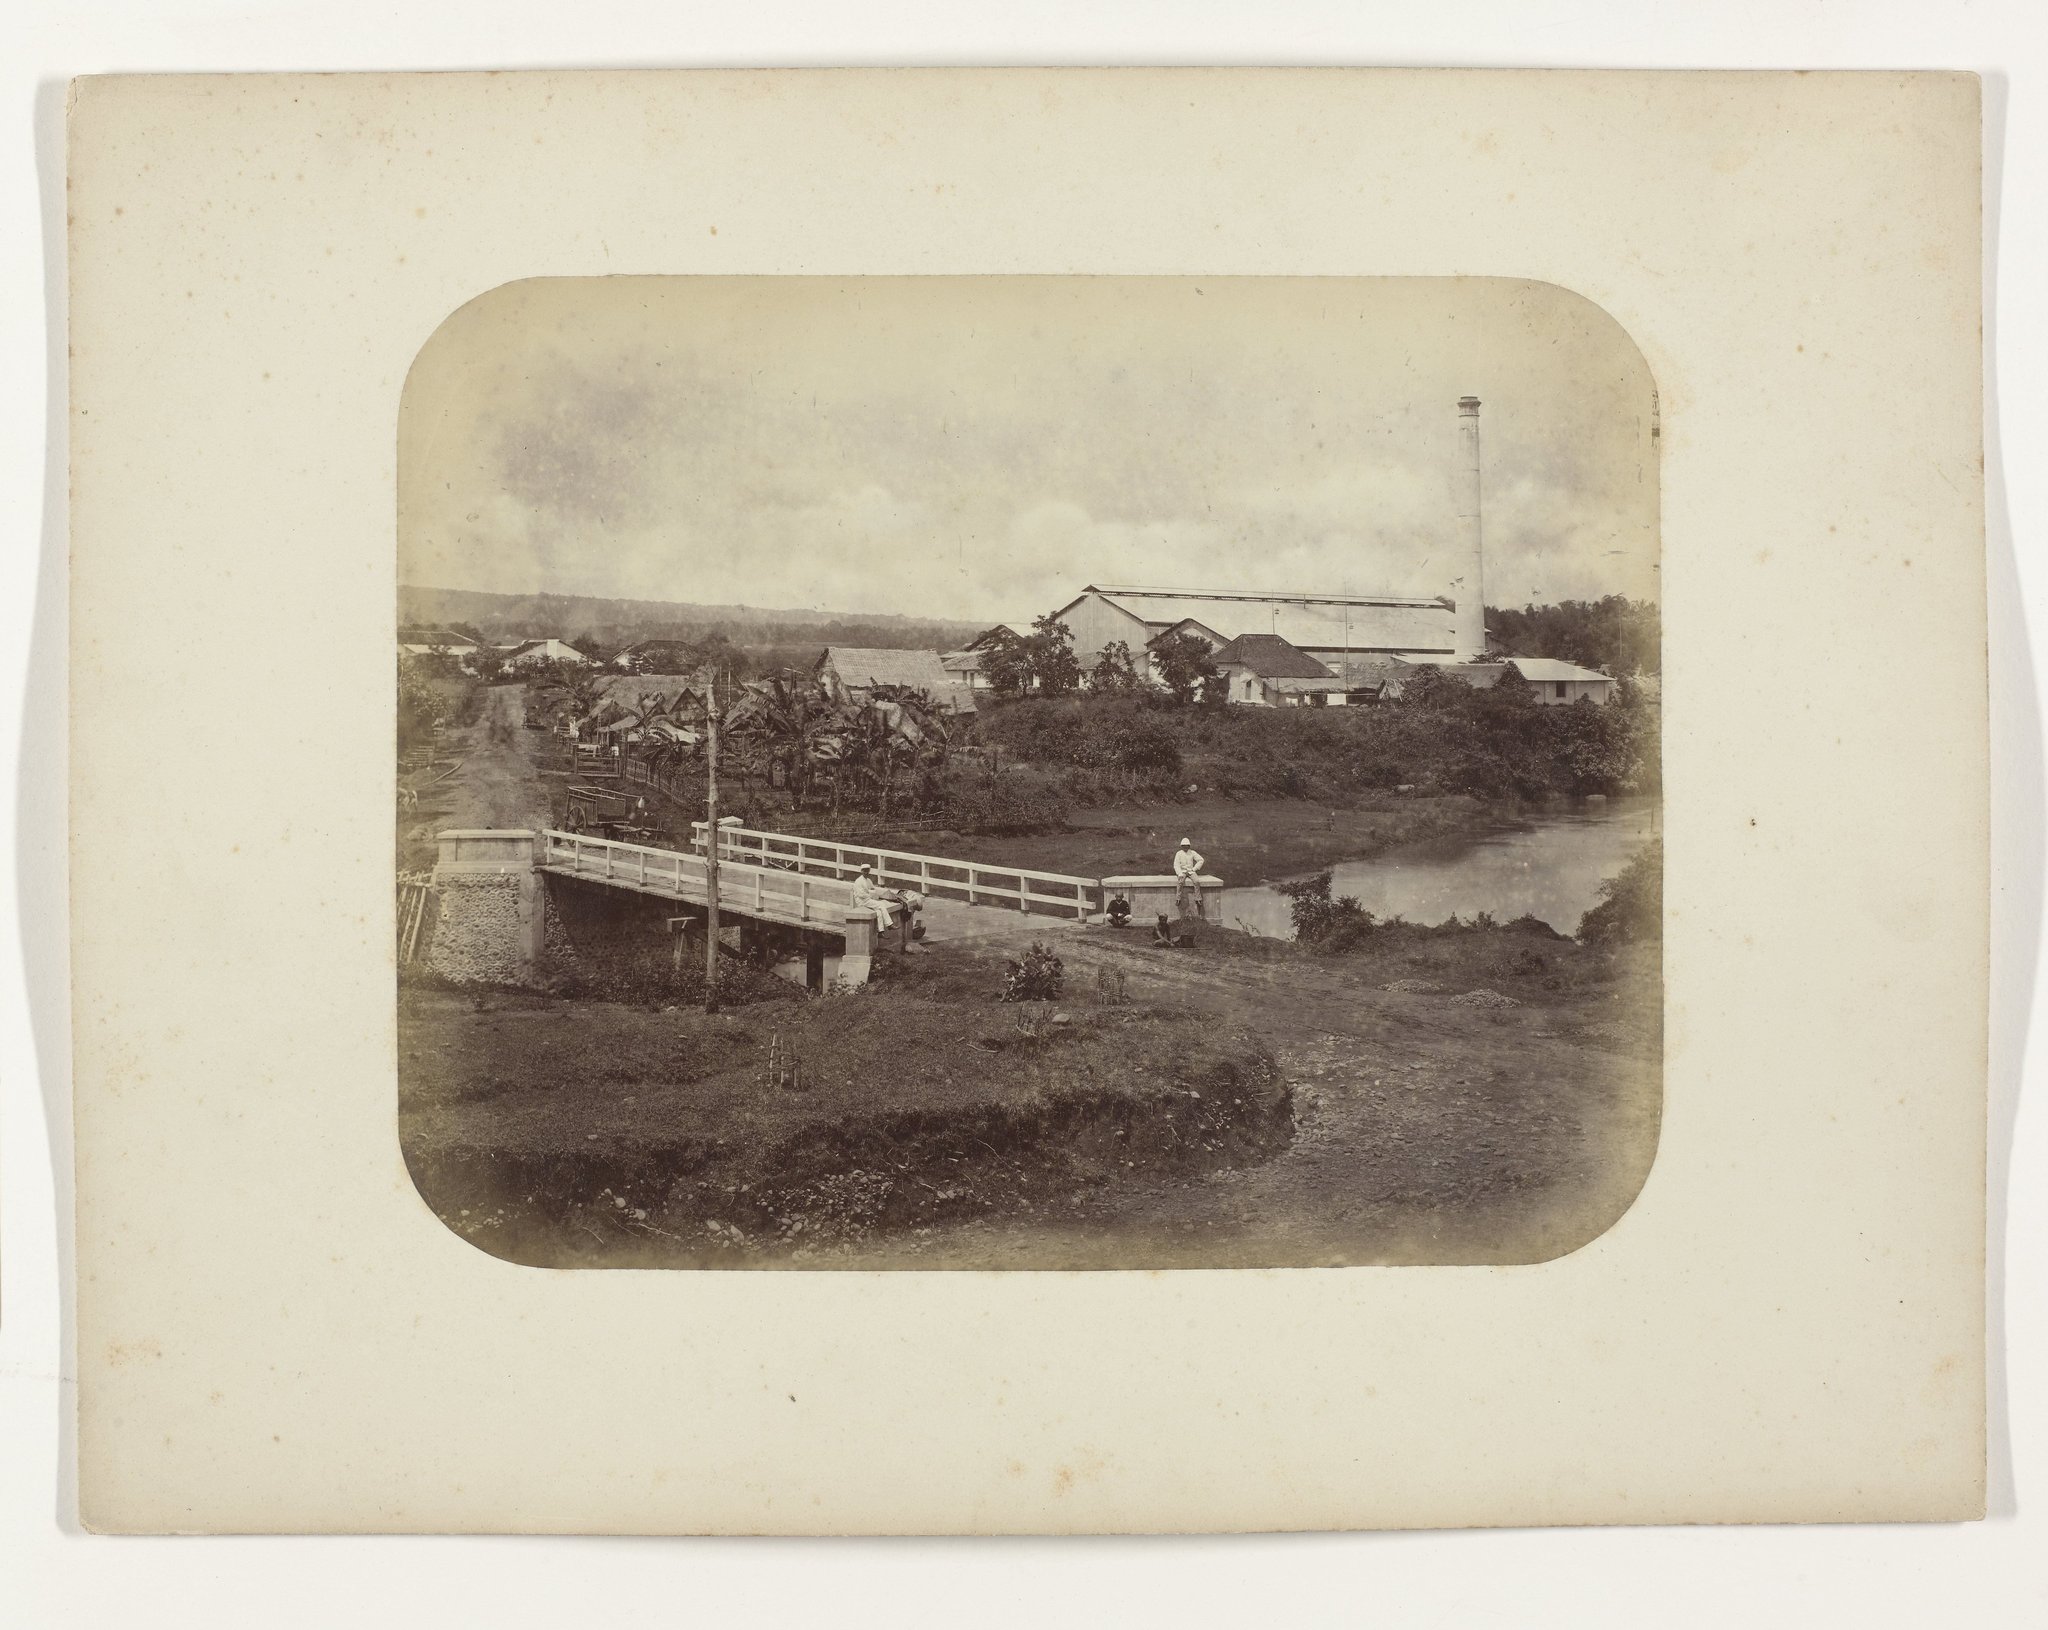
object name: photograph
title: Een suikerfabriek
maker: herman salzwedel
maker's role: fotograaf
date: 1876-1884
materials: photographic support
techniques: albumen print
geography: surabaya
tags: utrecht, colonial system, factory-building, (non-fruit) products of plants or trees: sugarcane, java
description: Een suikerfabriek met één schoorsteen met op de voorgrond een houten brug met twee zittende Europeanen en twee inlanders. Op de brug staat een lege kar. De fabriek staat rechts op de achtergrond. Onderdeel van het fotoalbum door de Soerabayasche Vereeniging van Suikerfabrikanten aangeboden aan Frederik Beyerinck, resident van Soerabaja.